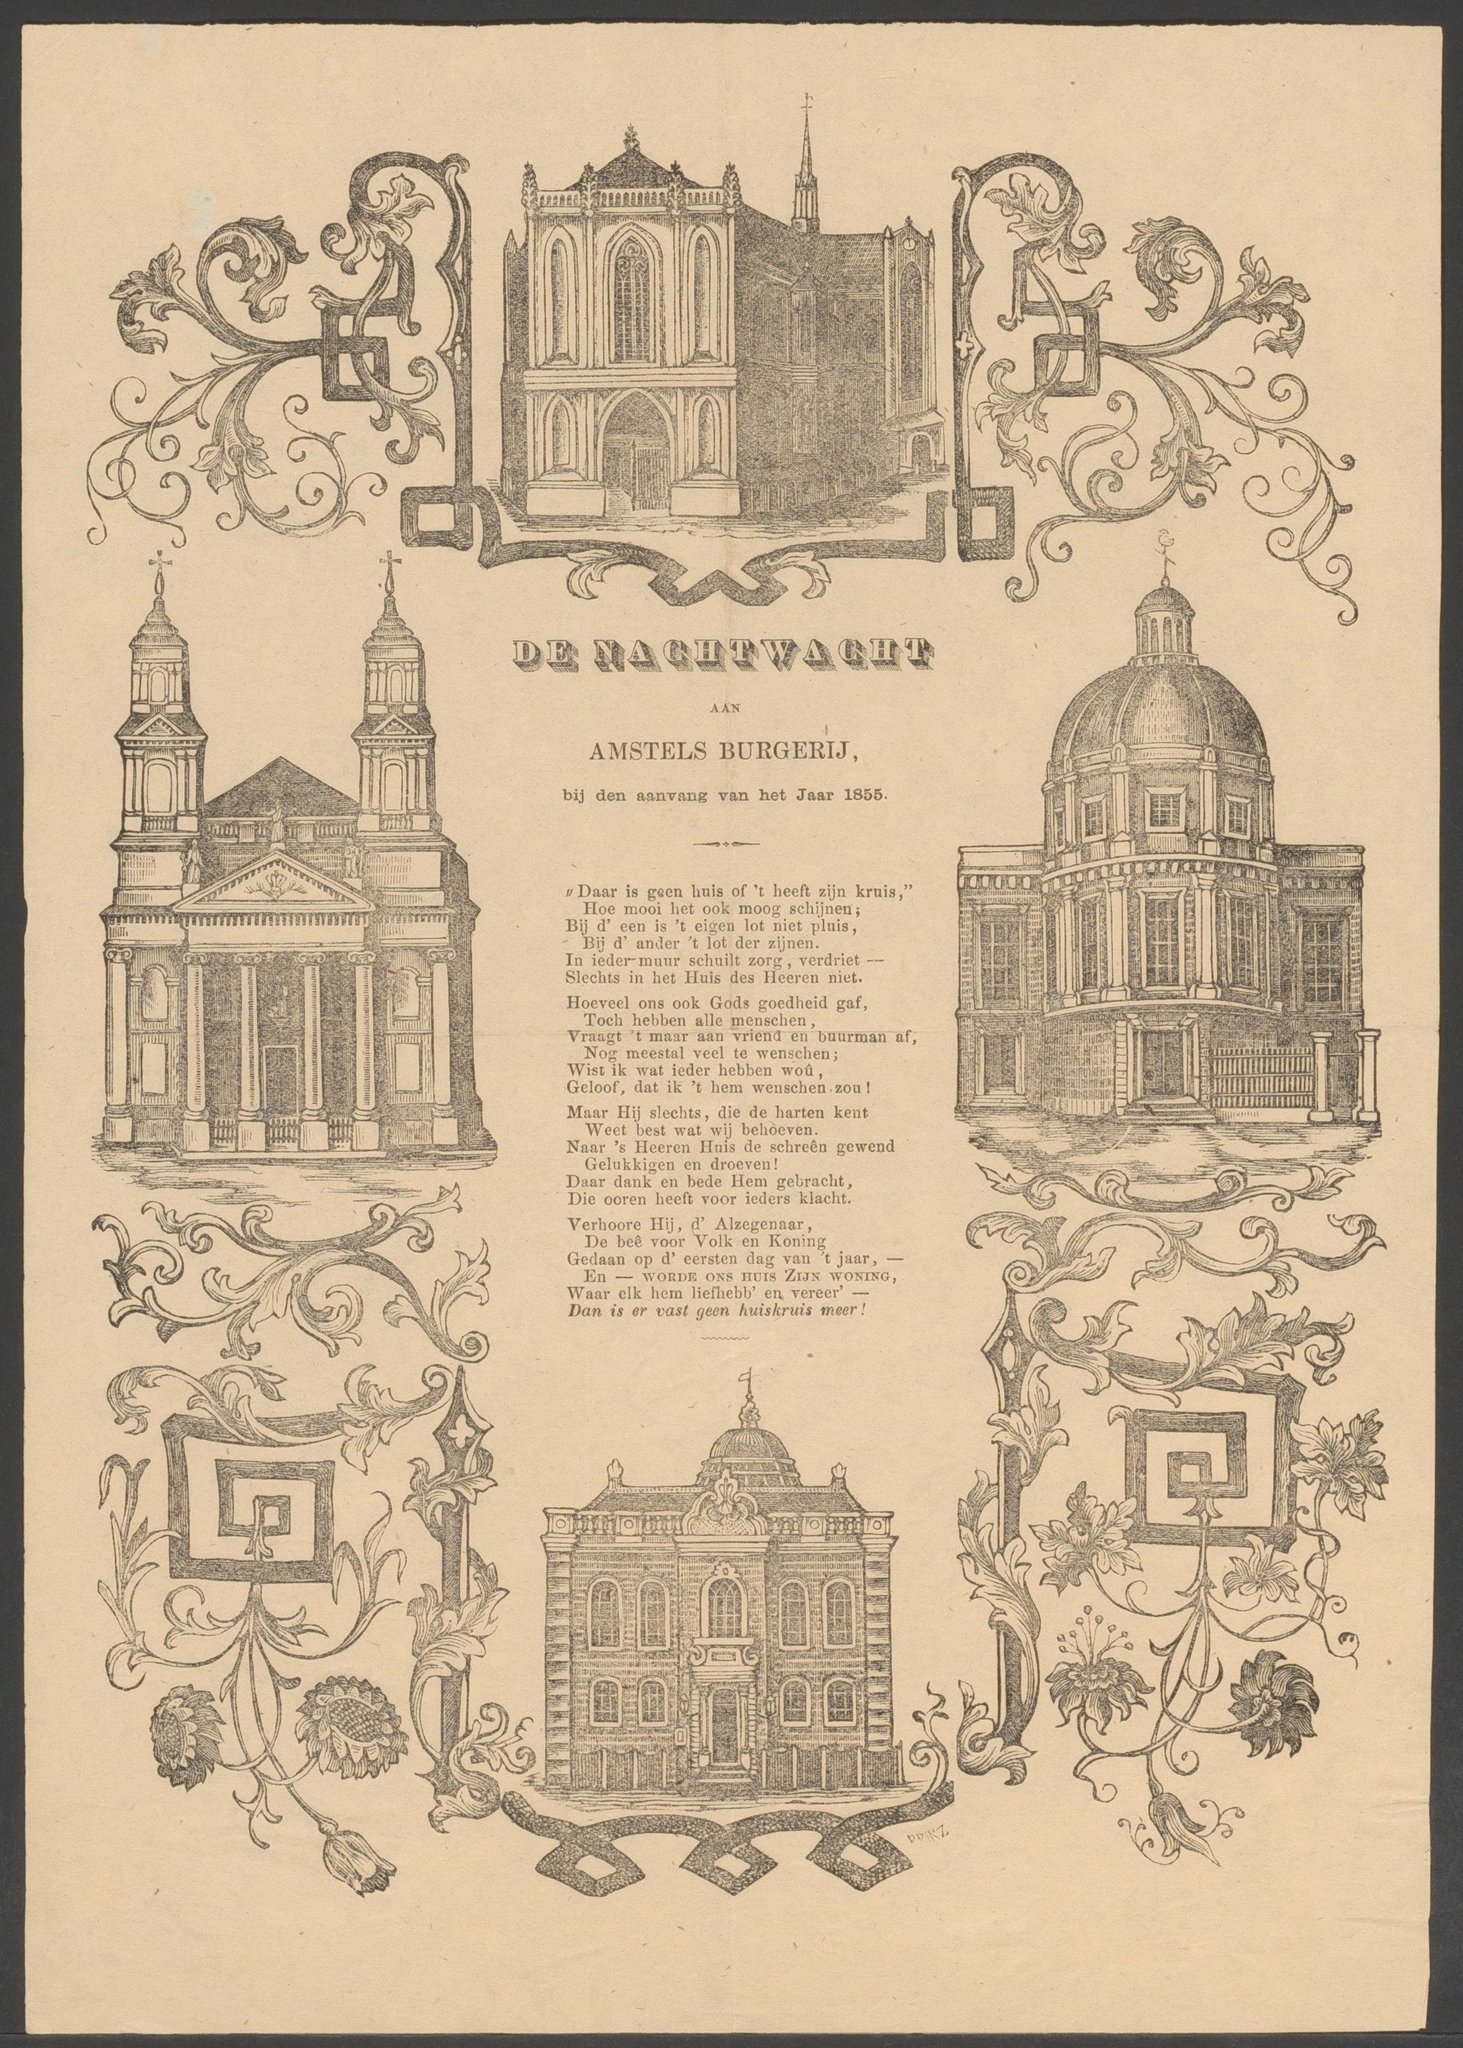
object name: print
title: De Nachtwacht aan Amstels Burgerij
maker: friedrich robert prinz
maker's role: print maker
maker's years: 1820-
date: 1854-1855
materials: paper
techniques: letterpress printing, engraving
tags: night patrol, church (exterior), amsterdam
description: Nieuwjaarswens van de Amsterdamse nachtwacht (ratelwacht) voor het jaar 1855. Centraal een gedicht in vier verzen, omringd door gebouwen tussen bladranken: de onvoltooide toren van de Nieuwe Kerk, de Mozes en Aäronkerk, de Ronde Lutherse Kerk en de Hoogduitse Synagoge. Onderwerpsrubrieken binnen de Atlas Zeden en Gewoonten: Zeden en gewoonten in engeren zin, Volksleven, Volksbladen, Nieuwjaars- en Kerstwenschen, Amsterdam.